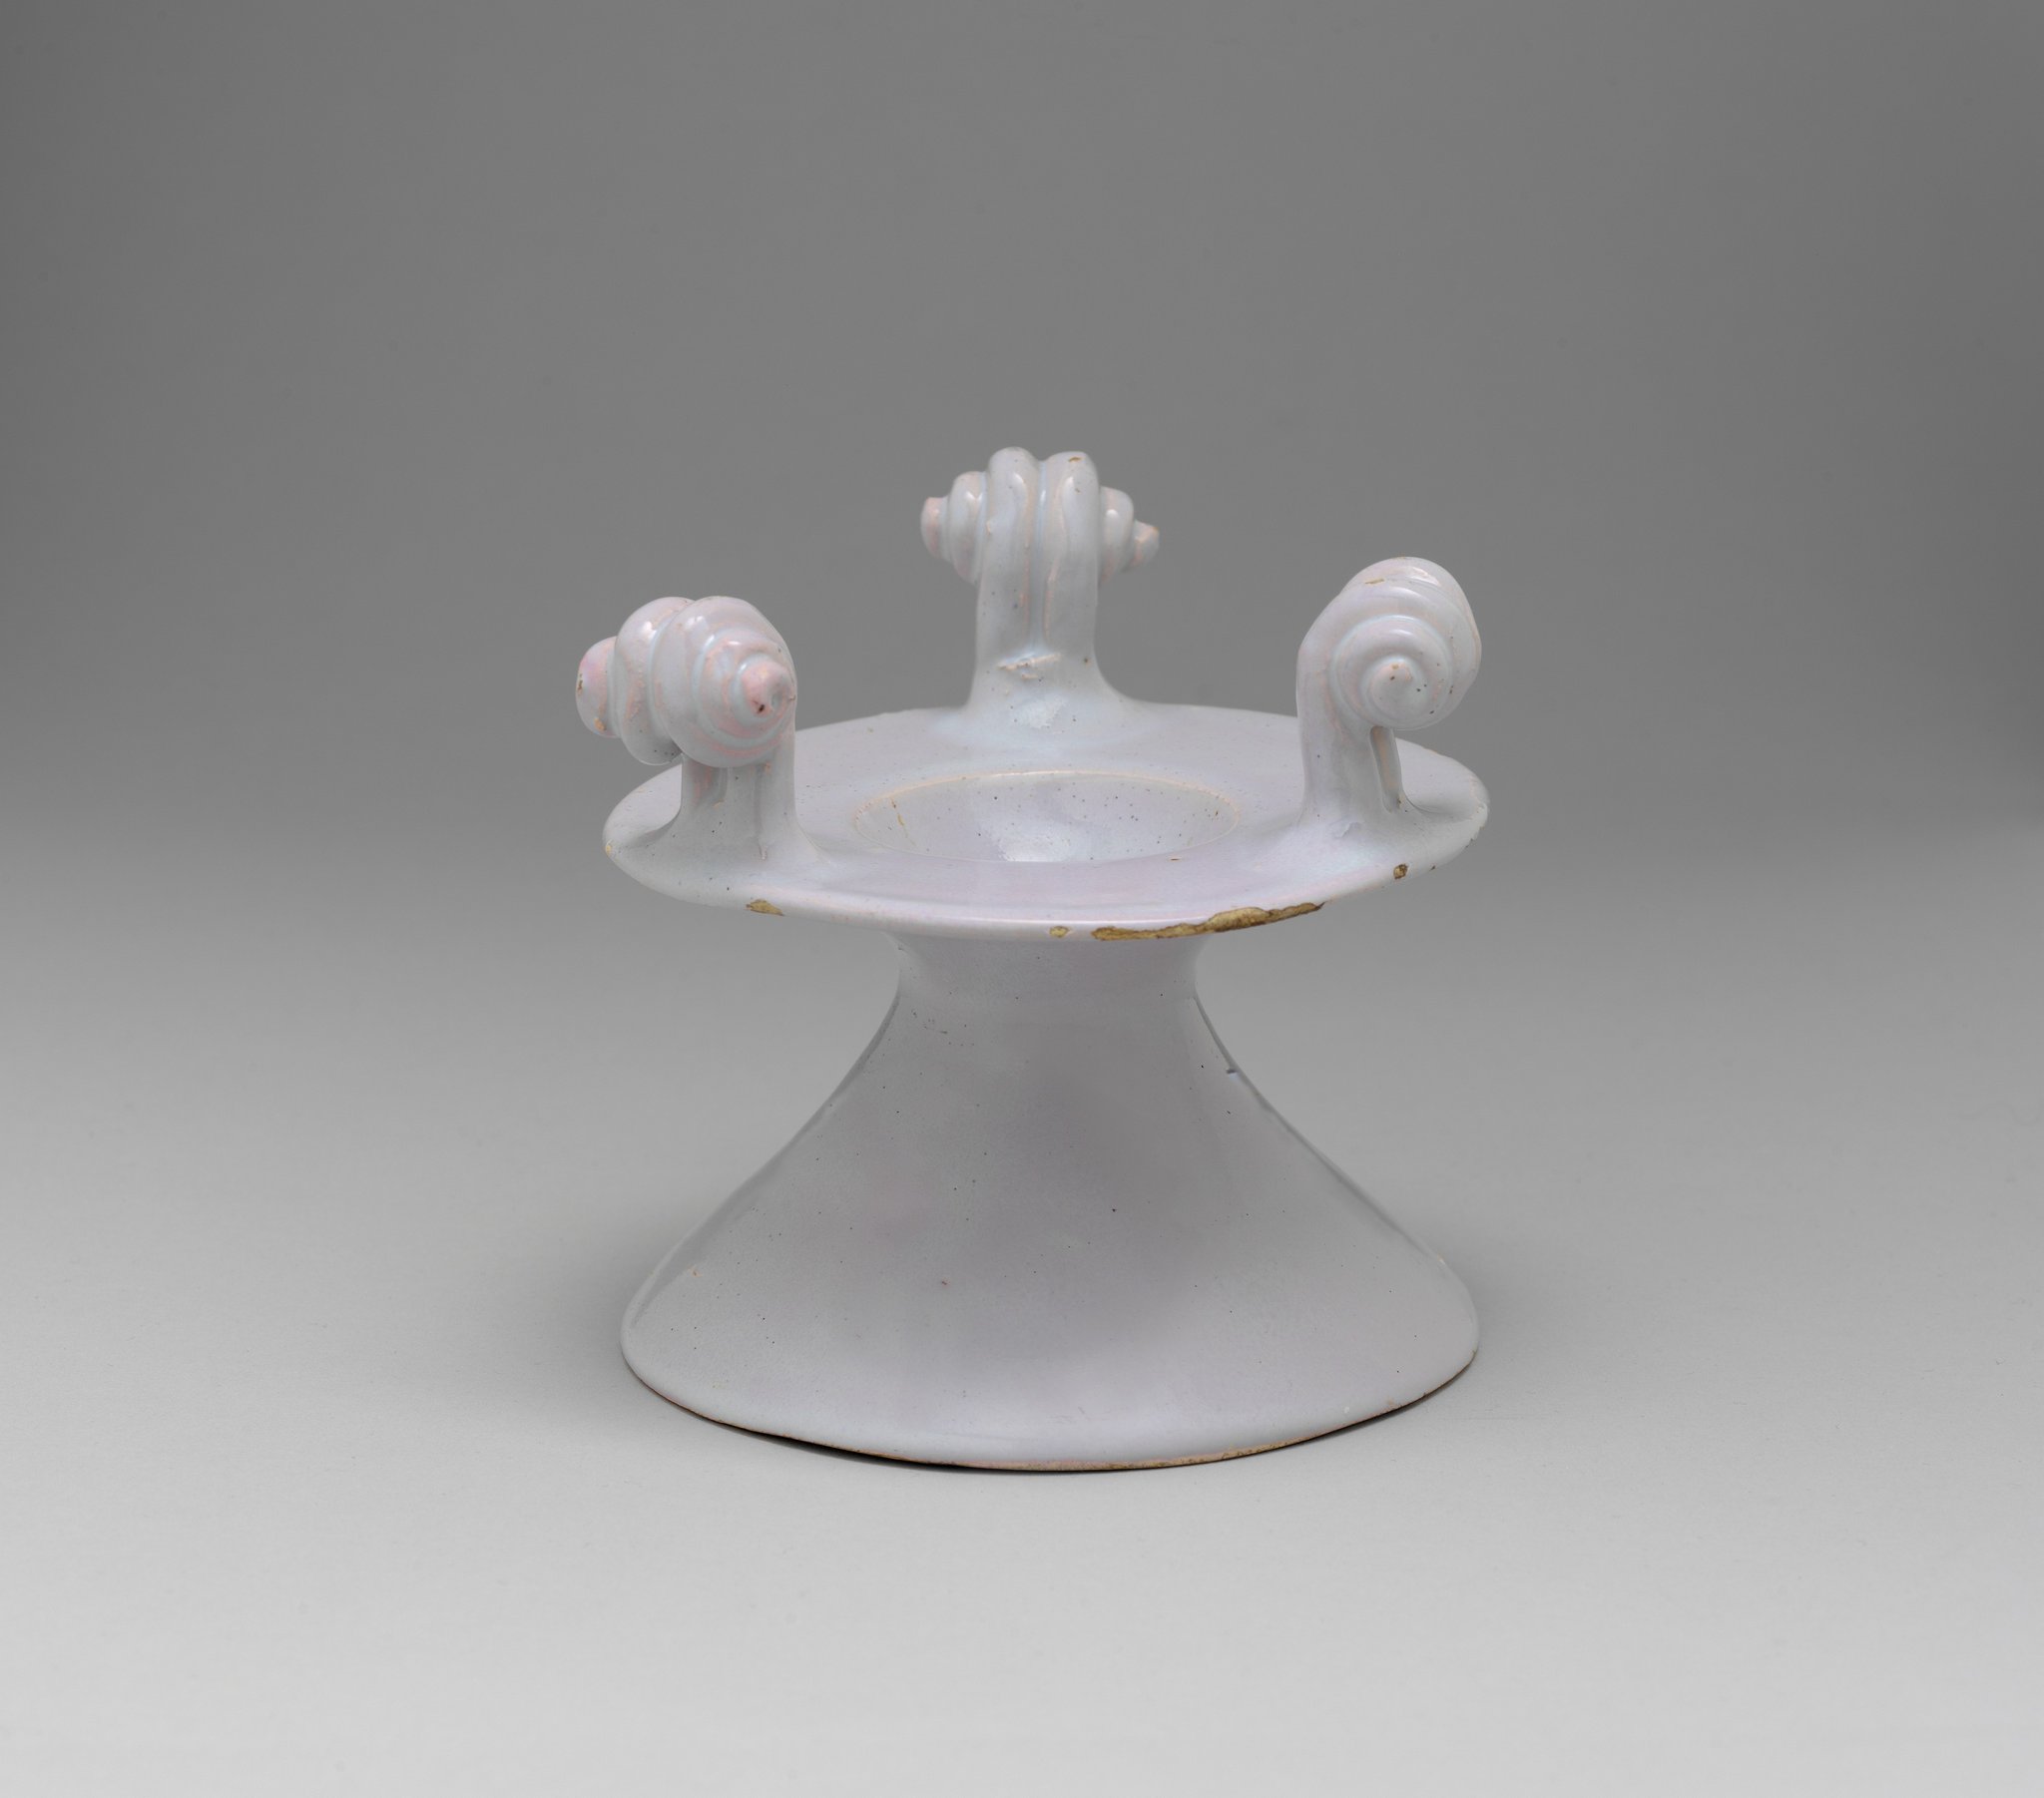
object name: salt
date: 1651-1700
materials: earthenware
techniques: glazing